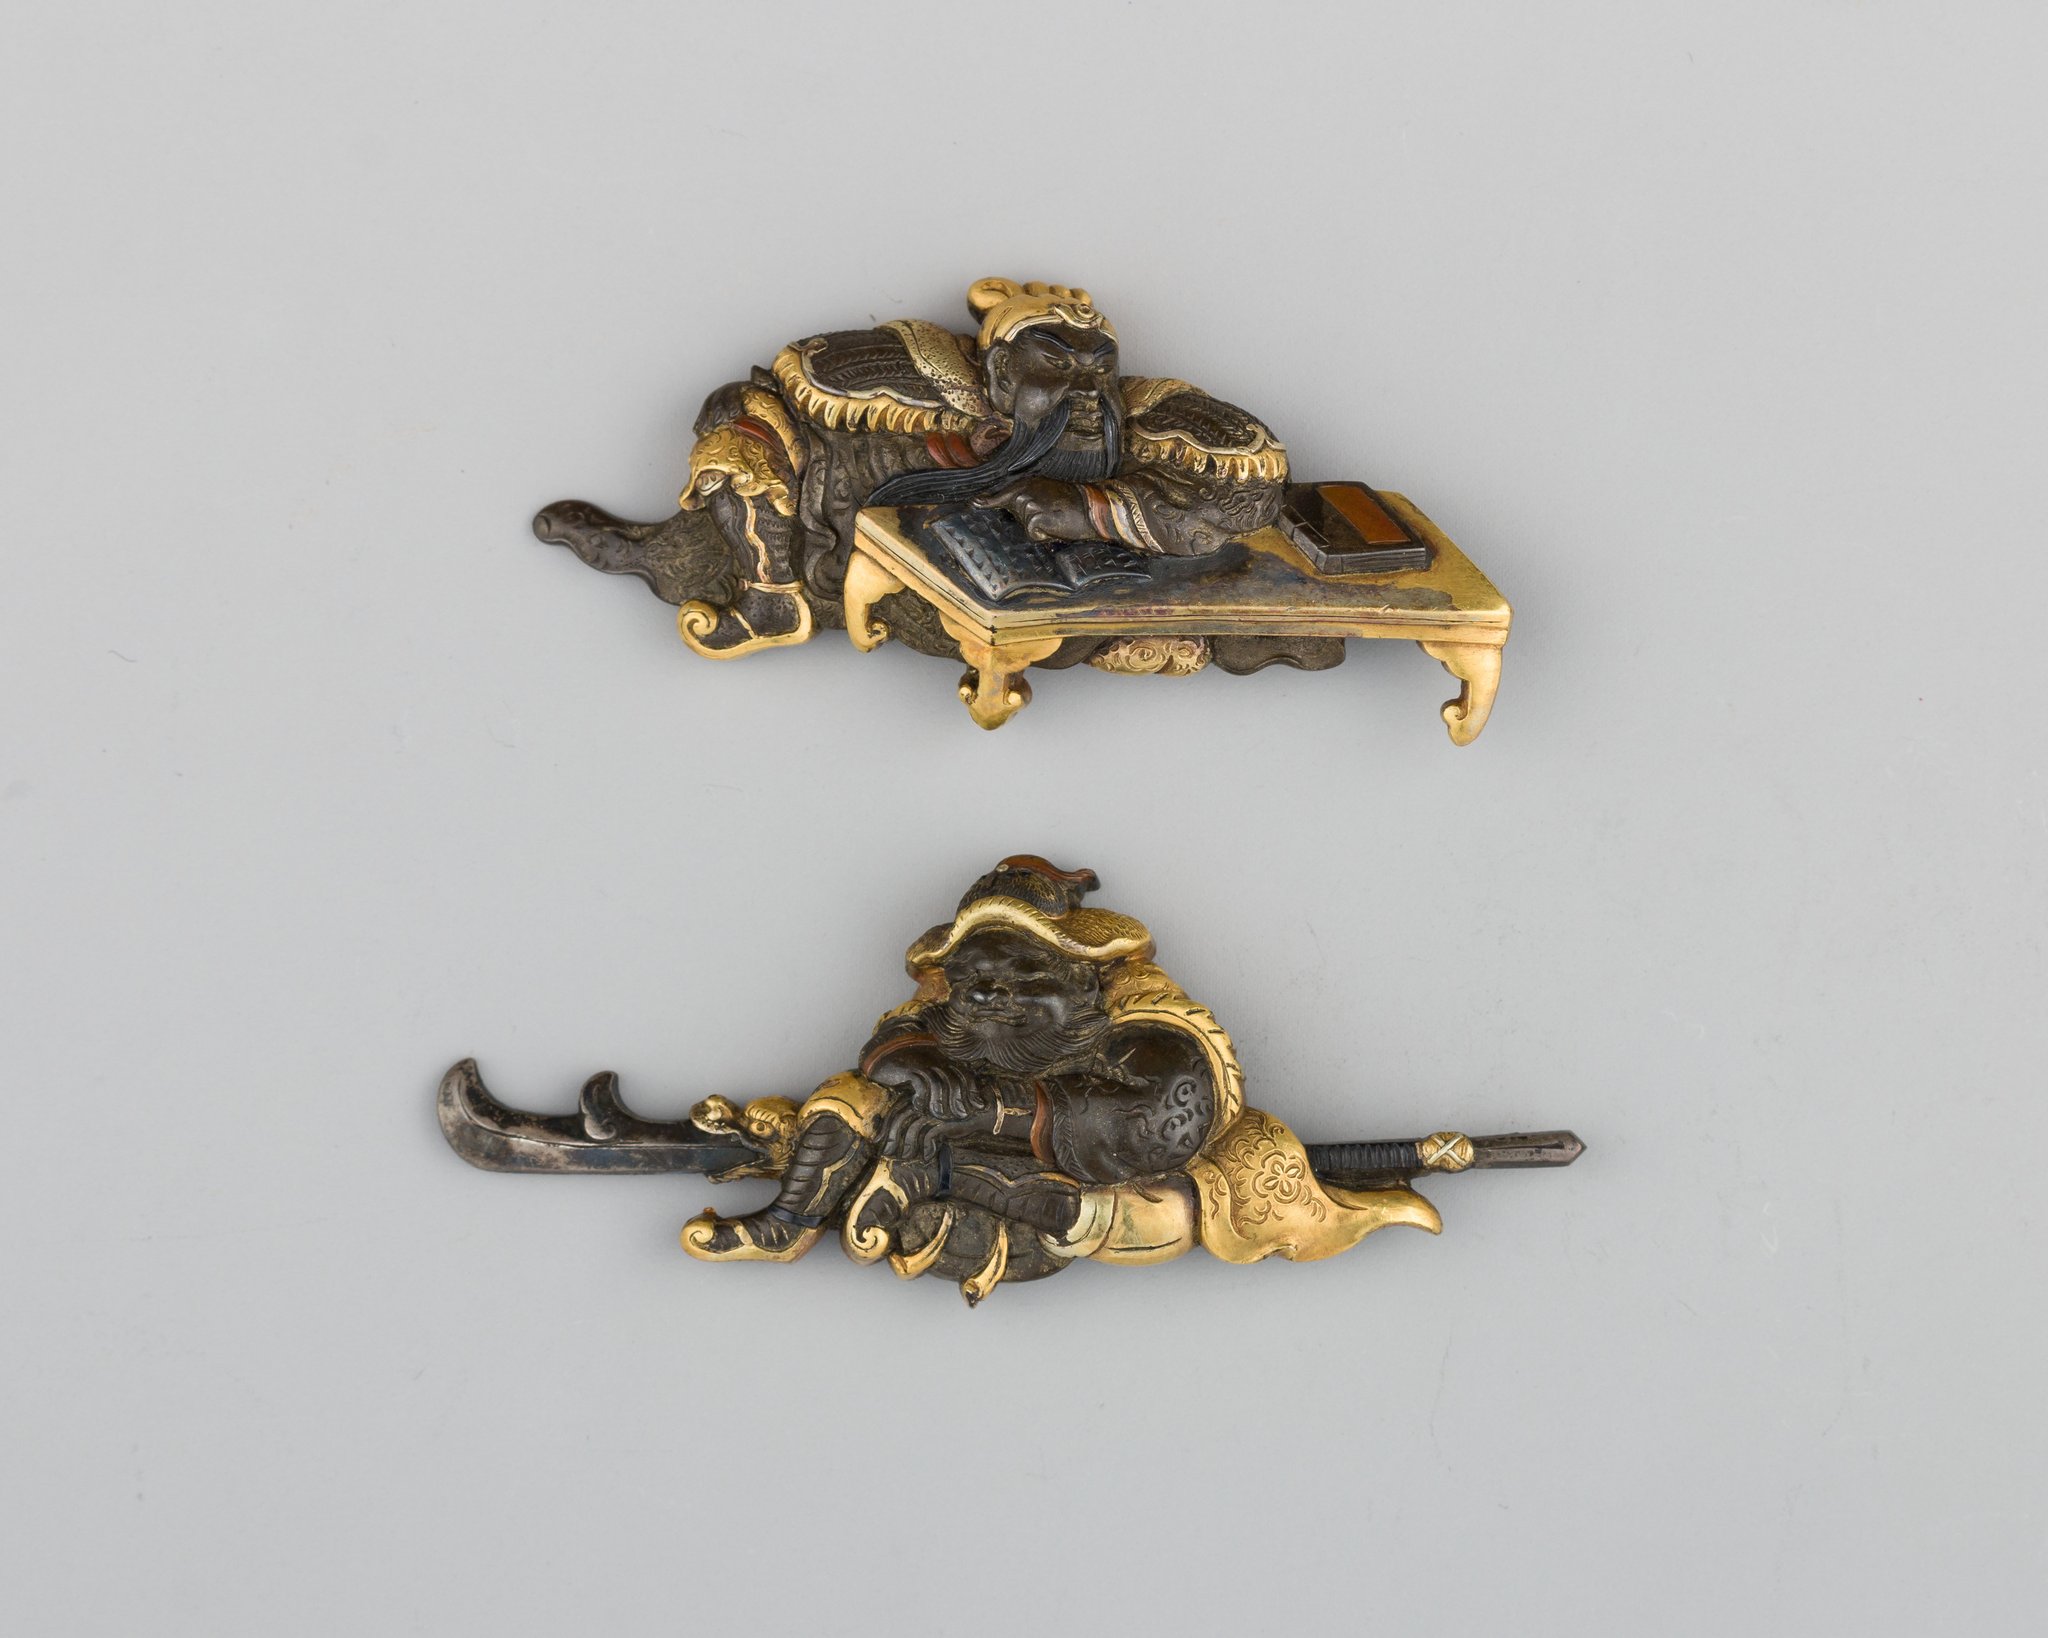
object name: pair of sword grip ornament menuki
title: Pair of Sword-Grip Ornaments (Menuki)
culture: japanese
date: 1701-1800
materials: copper, gold alloy, silver alloy, gold, silver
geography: japan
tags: men,reading